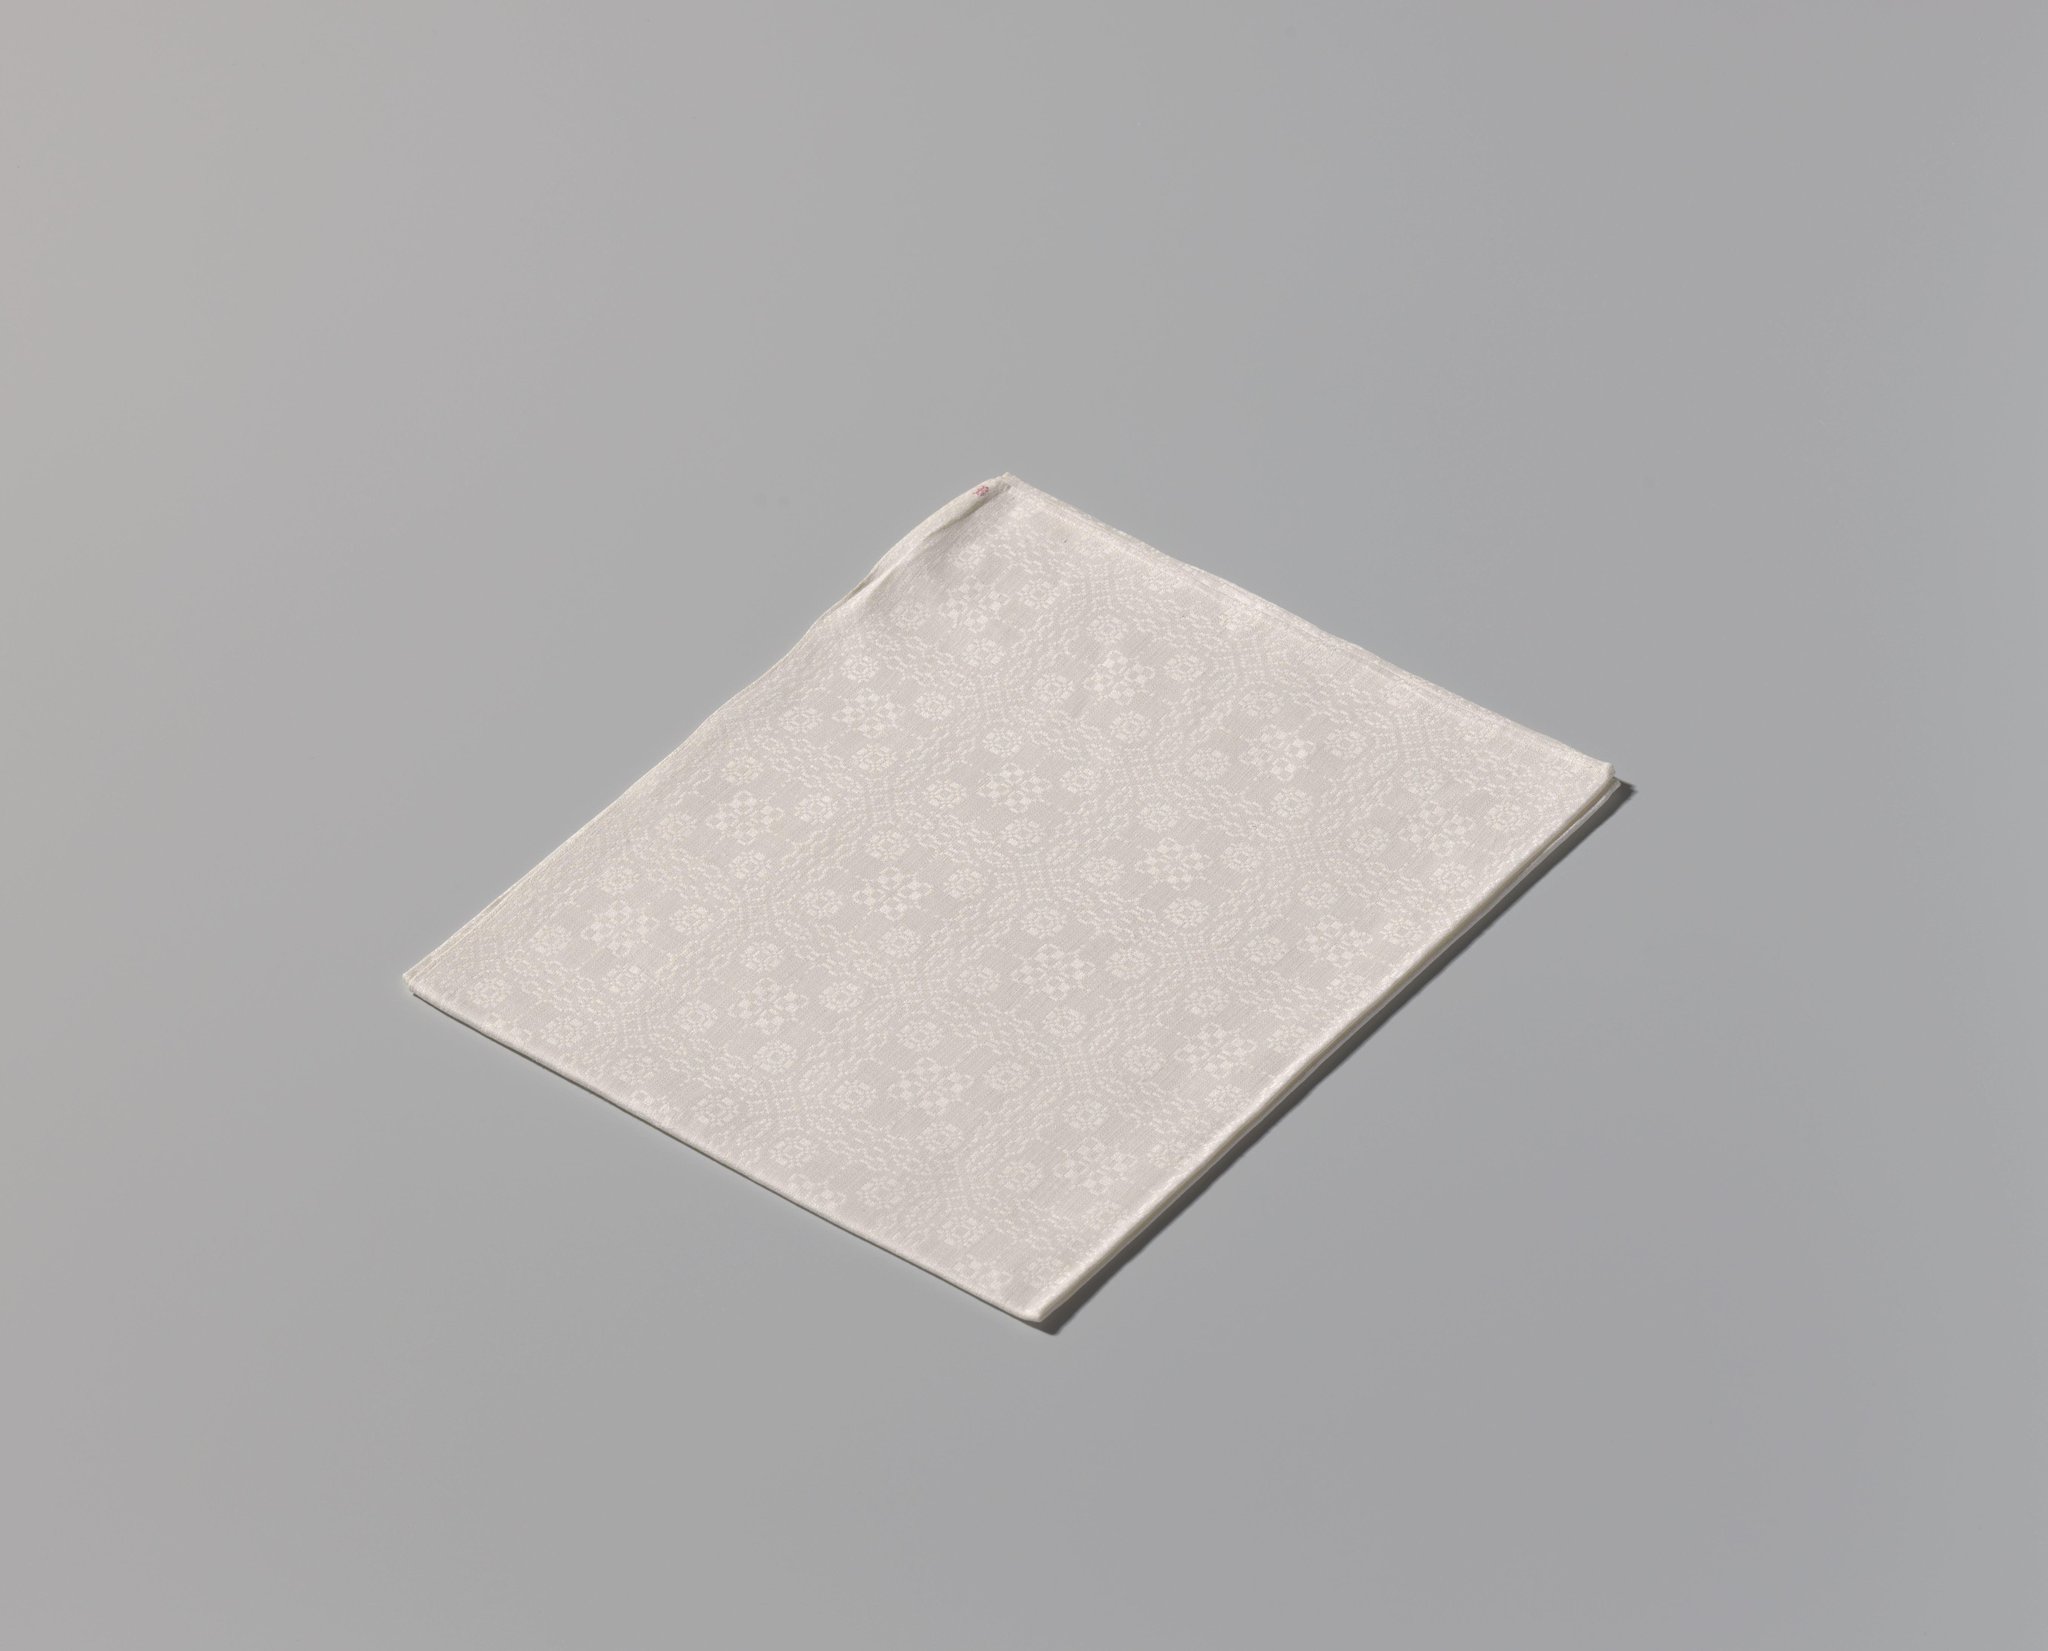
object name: napkin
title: Servet van pellendamast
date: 1675-1725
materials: linen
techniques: weave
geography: north brabant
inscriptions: mark: ‘B’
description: Servet van pellendamast. Elkaar snijdende rijen van ruiten vormen vierkanten, waarbinnen vijf blokken. Het servet is gehalveerd. Het servet hoort bij twaalf servetten en een tafellaken.